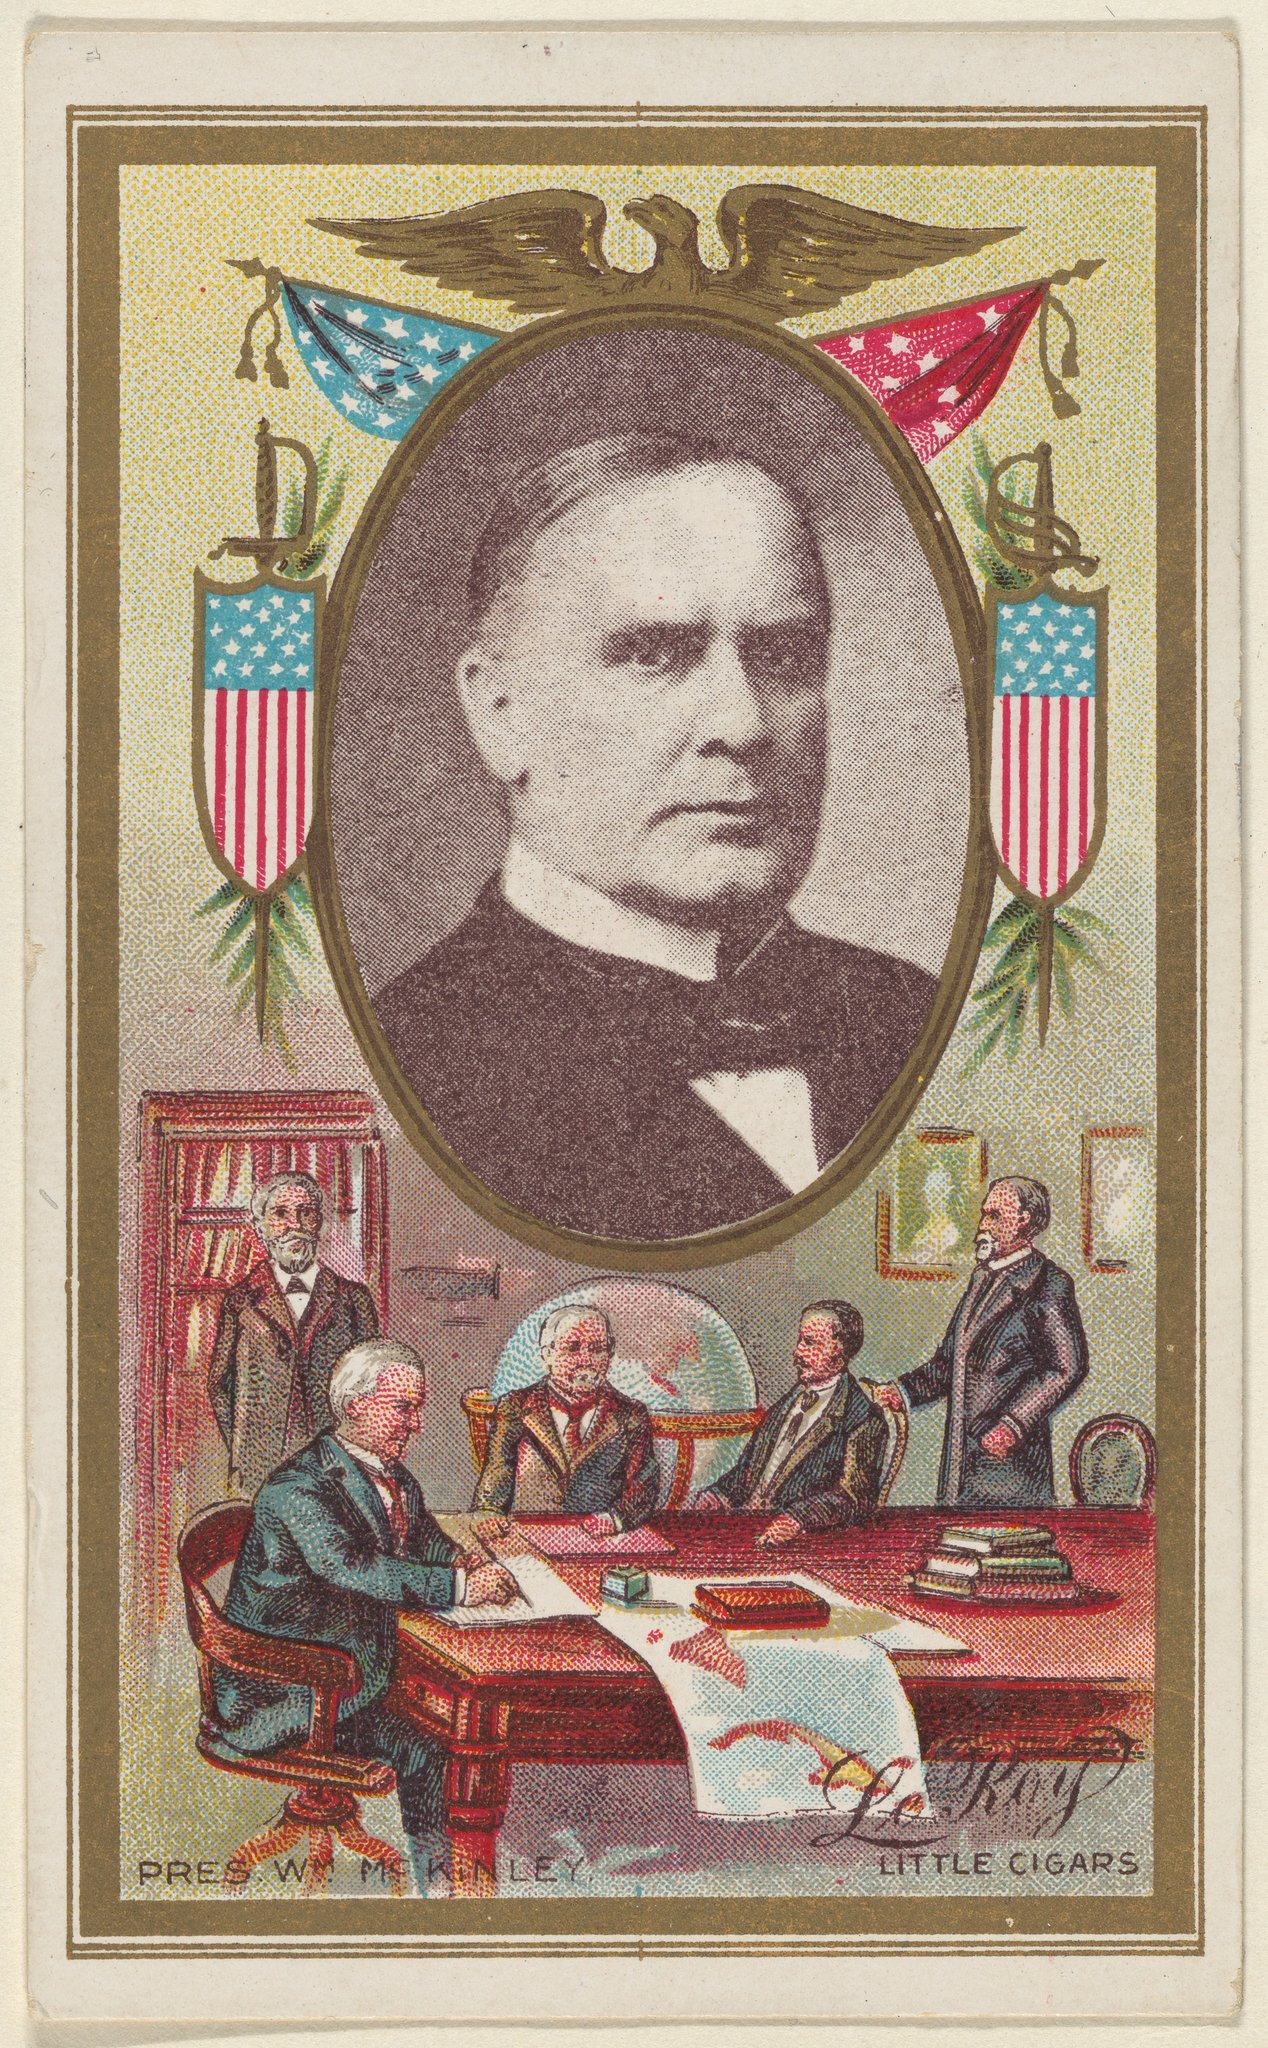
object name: print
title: President William McKinley, from the "Generals" series (T63), issued by LeRoy Little Cigars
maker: leroy little cigars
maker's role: publisher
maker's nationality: american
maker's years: 1850-1950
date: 1898-1901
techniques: color lithograph